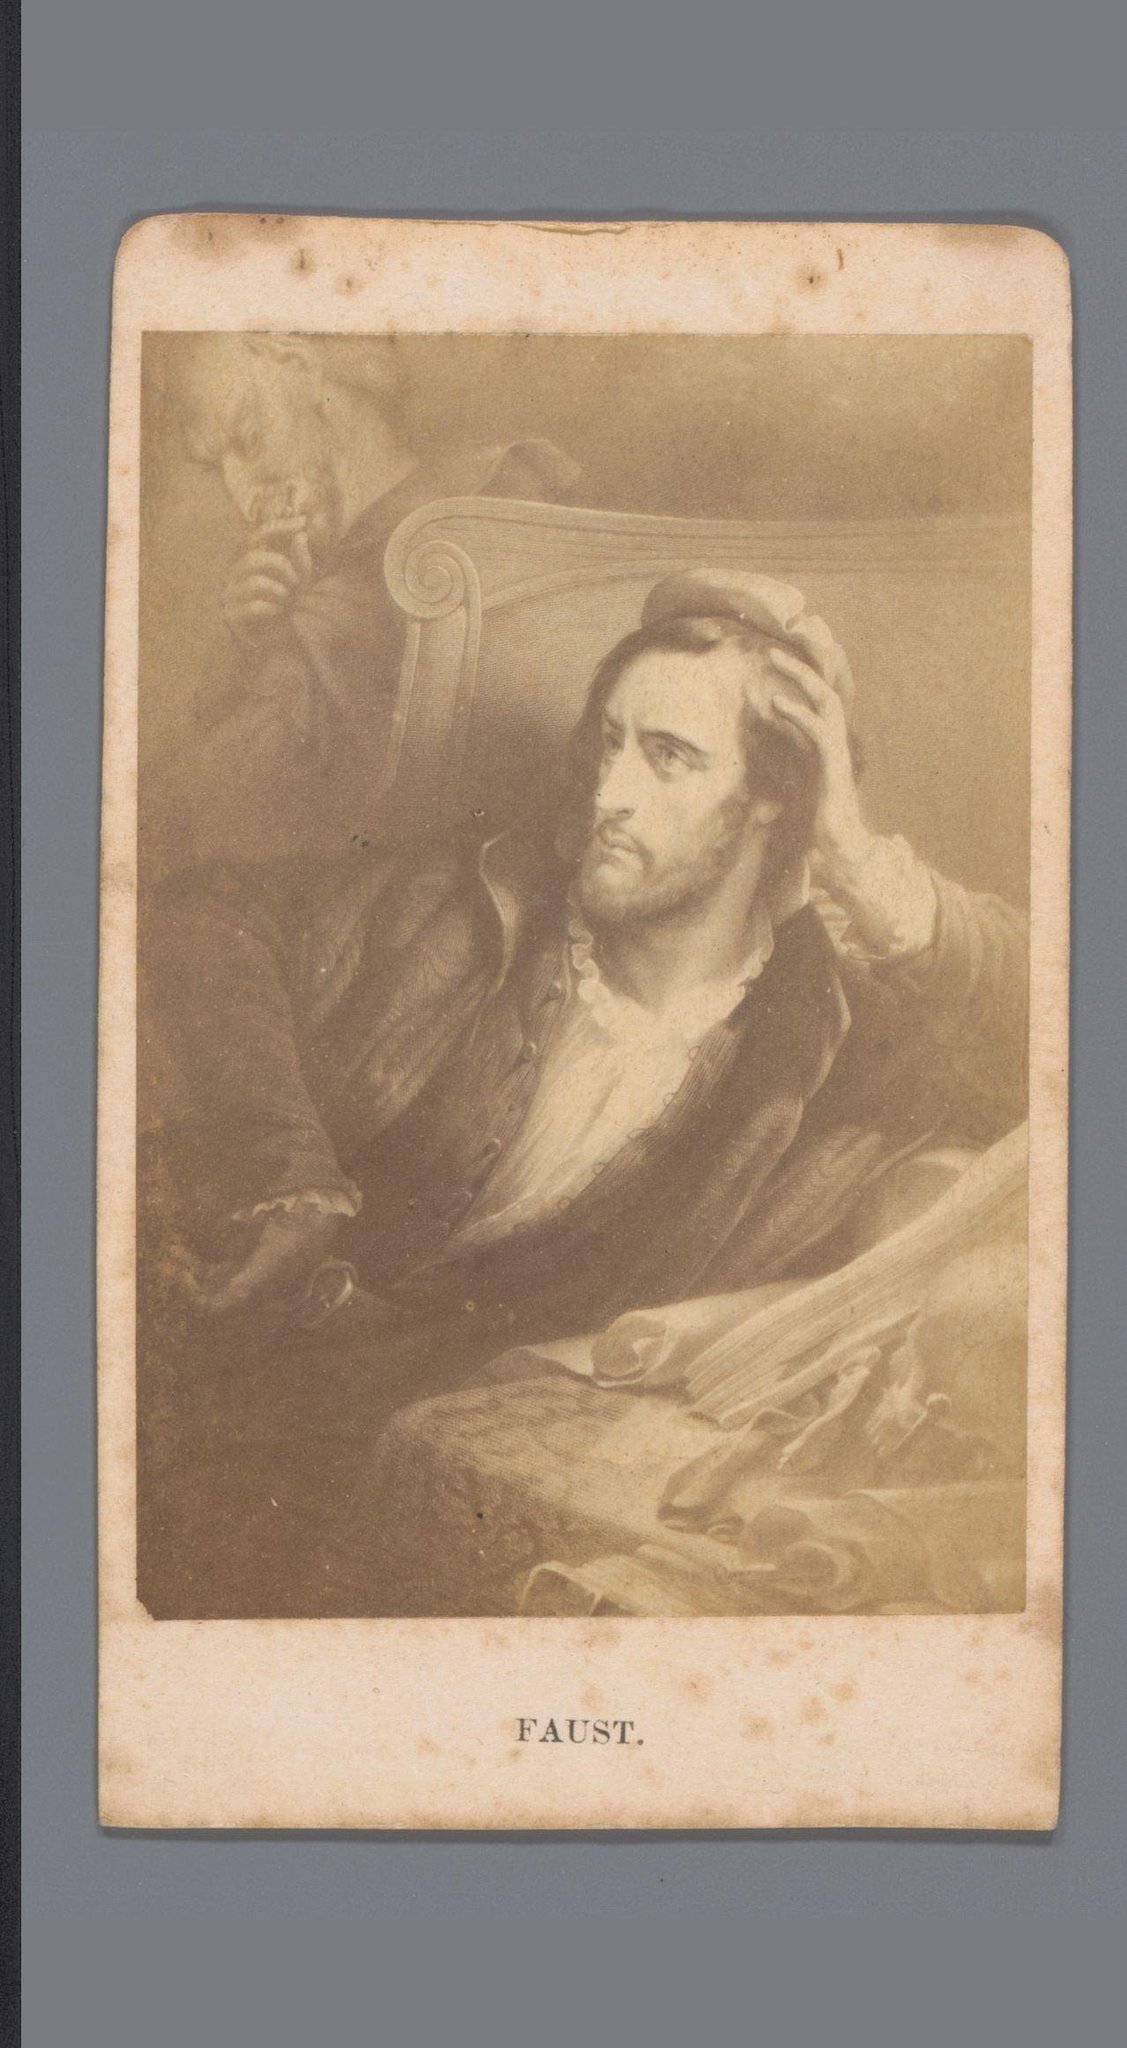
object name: carte de visite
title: Faust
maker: andries jager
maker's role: publisher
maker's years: 1825-1905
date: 1855-1885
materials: cardboard, paper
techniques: albumen print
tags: faust, mephistopheles, name of the demonic tempter in the literary versions of the faust legends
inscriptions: inscription: ‘A. Jager/ Water, 110./ Amsterdam.’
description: Het schilderij Faust dans son cabinet van Ary Scheffer (ca. 1848-1851) bevindt zich in het Musée de la Vie romantique, Parijs.